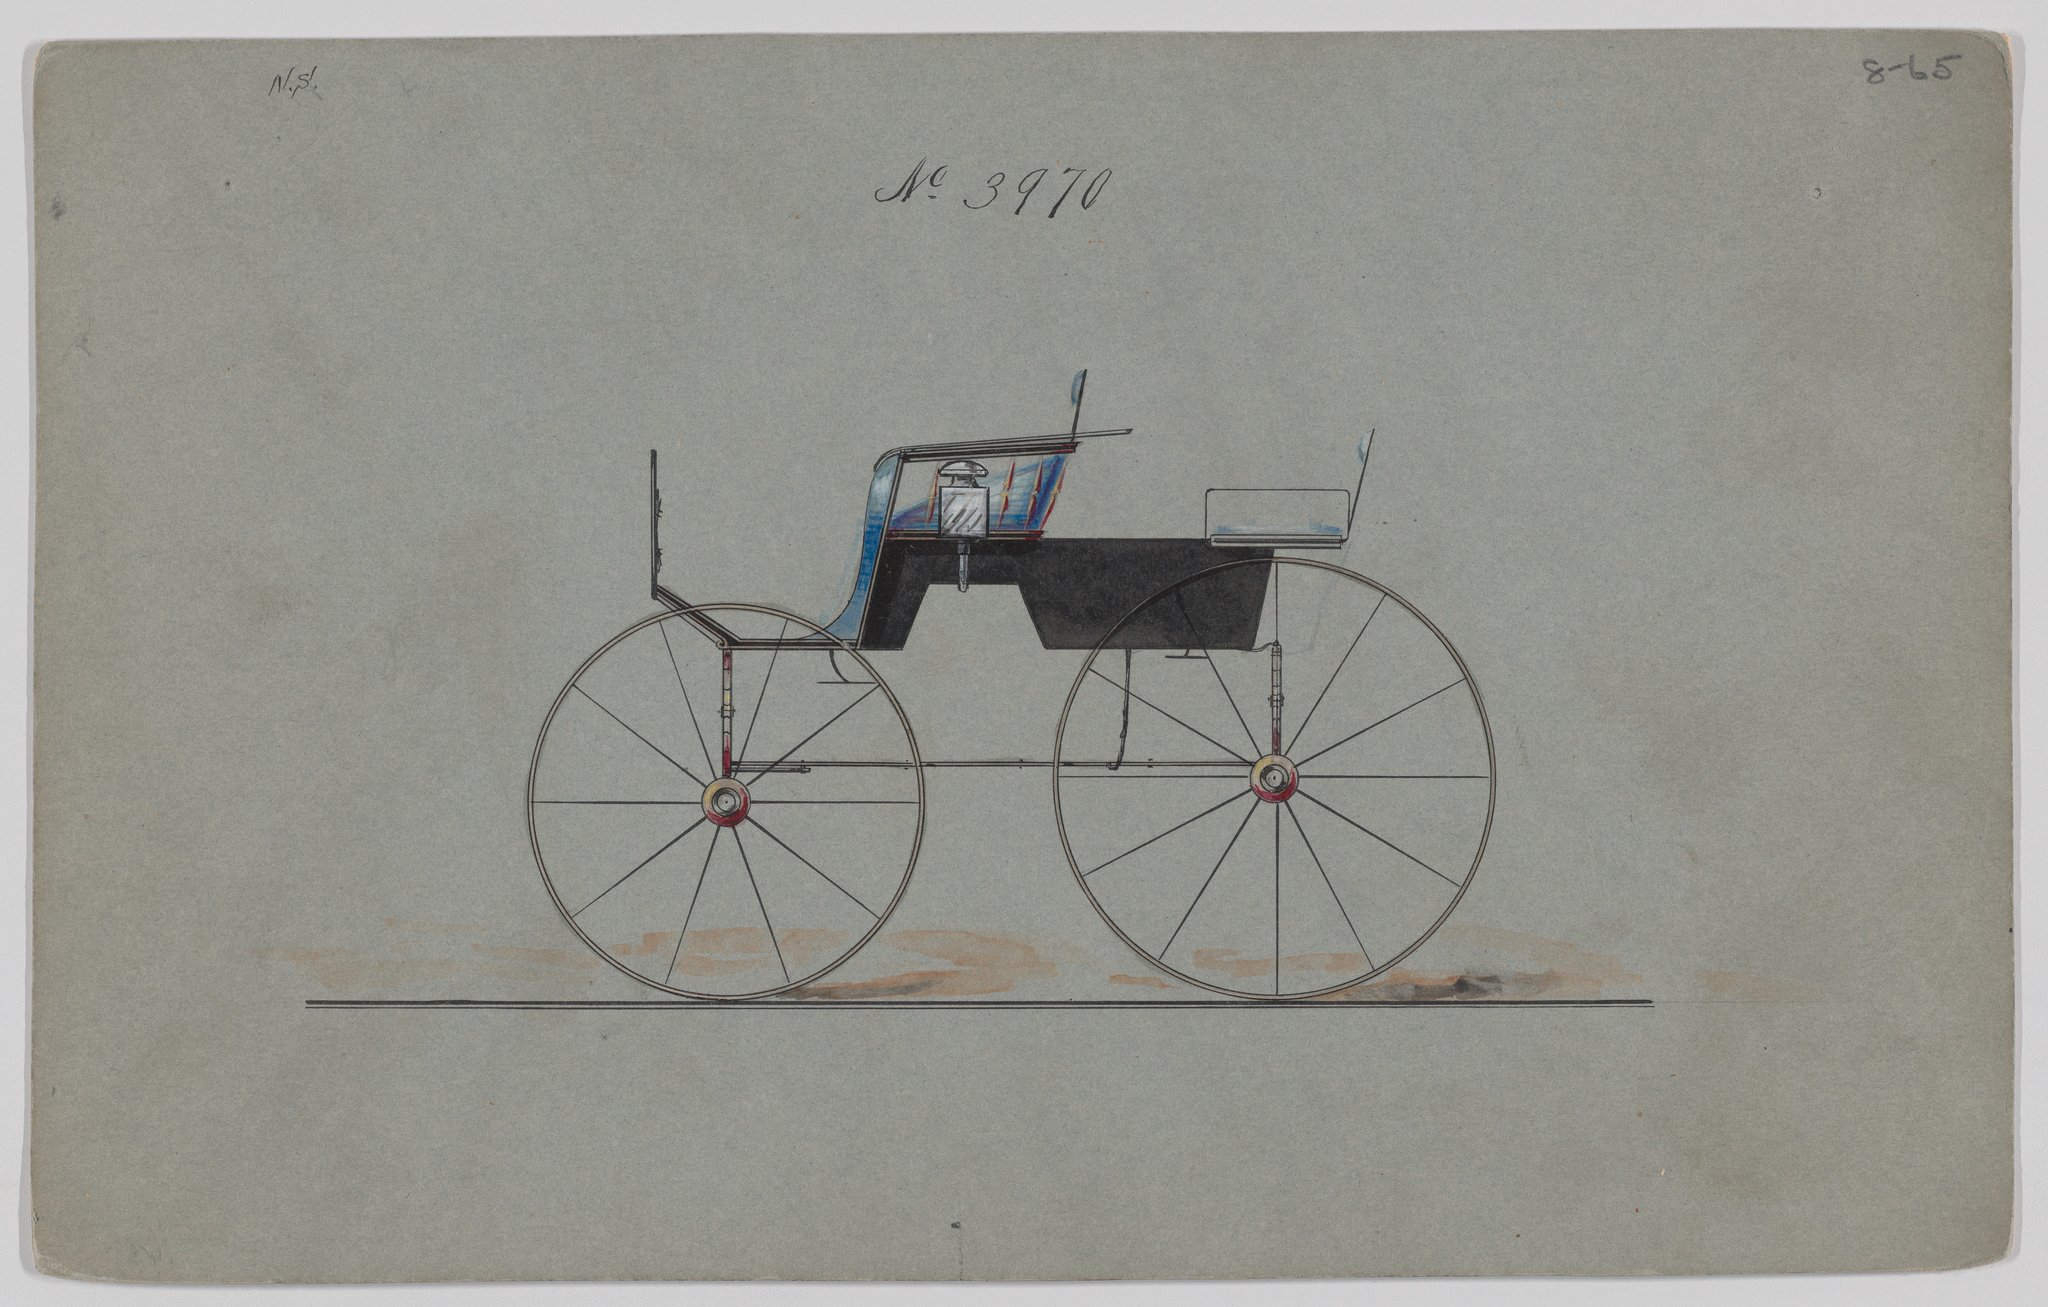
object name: drawing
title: Design for 4 seat Phaeton, no top, no. 3970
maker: brewster & co.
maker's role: manufacturer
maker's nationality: american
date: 1886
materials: gouache, ink, watercolor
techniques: pen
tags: carriages